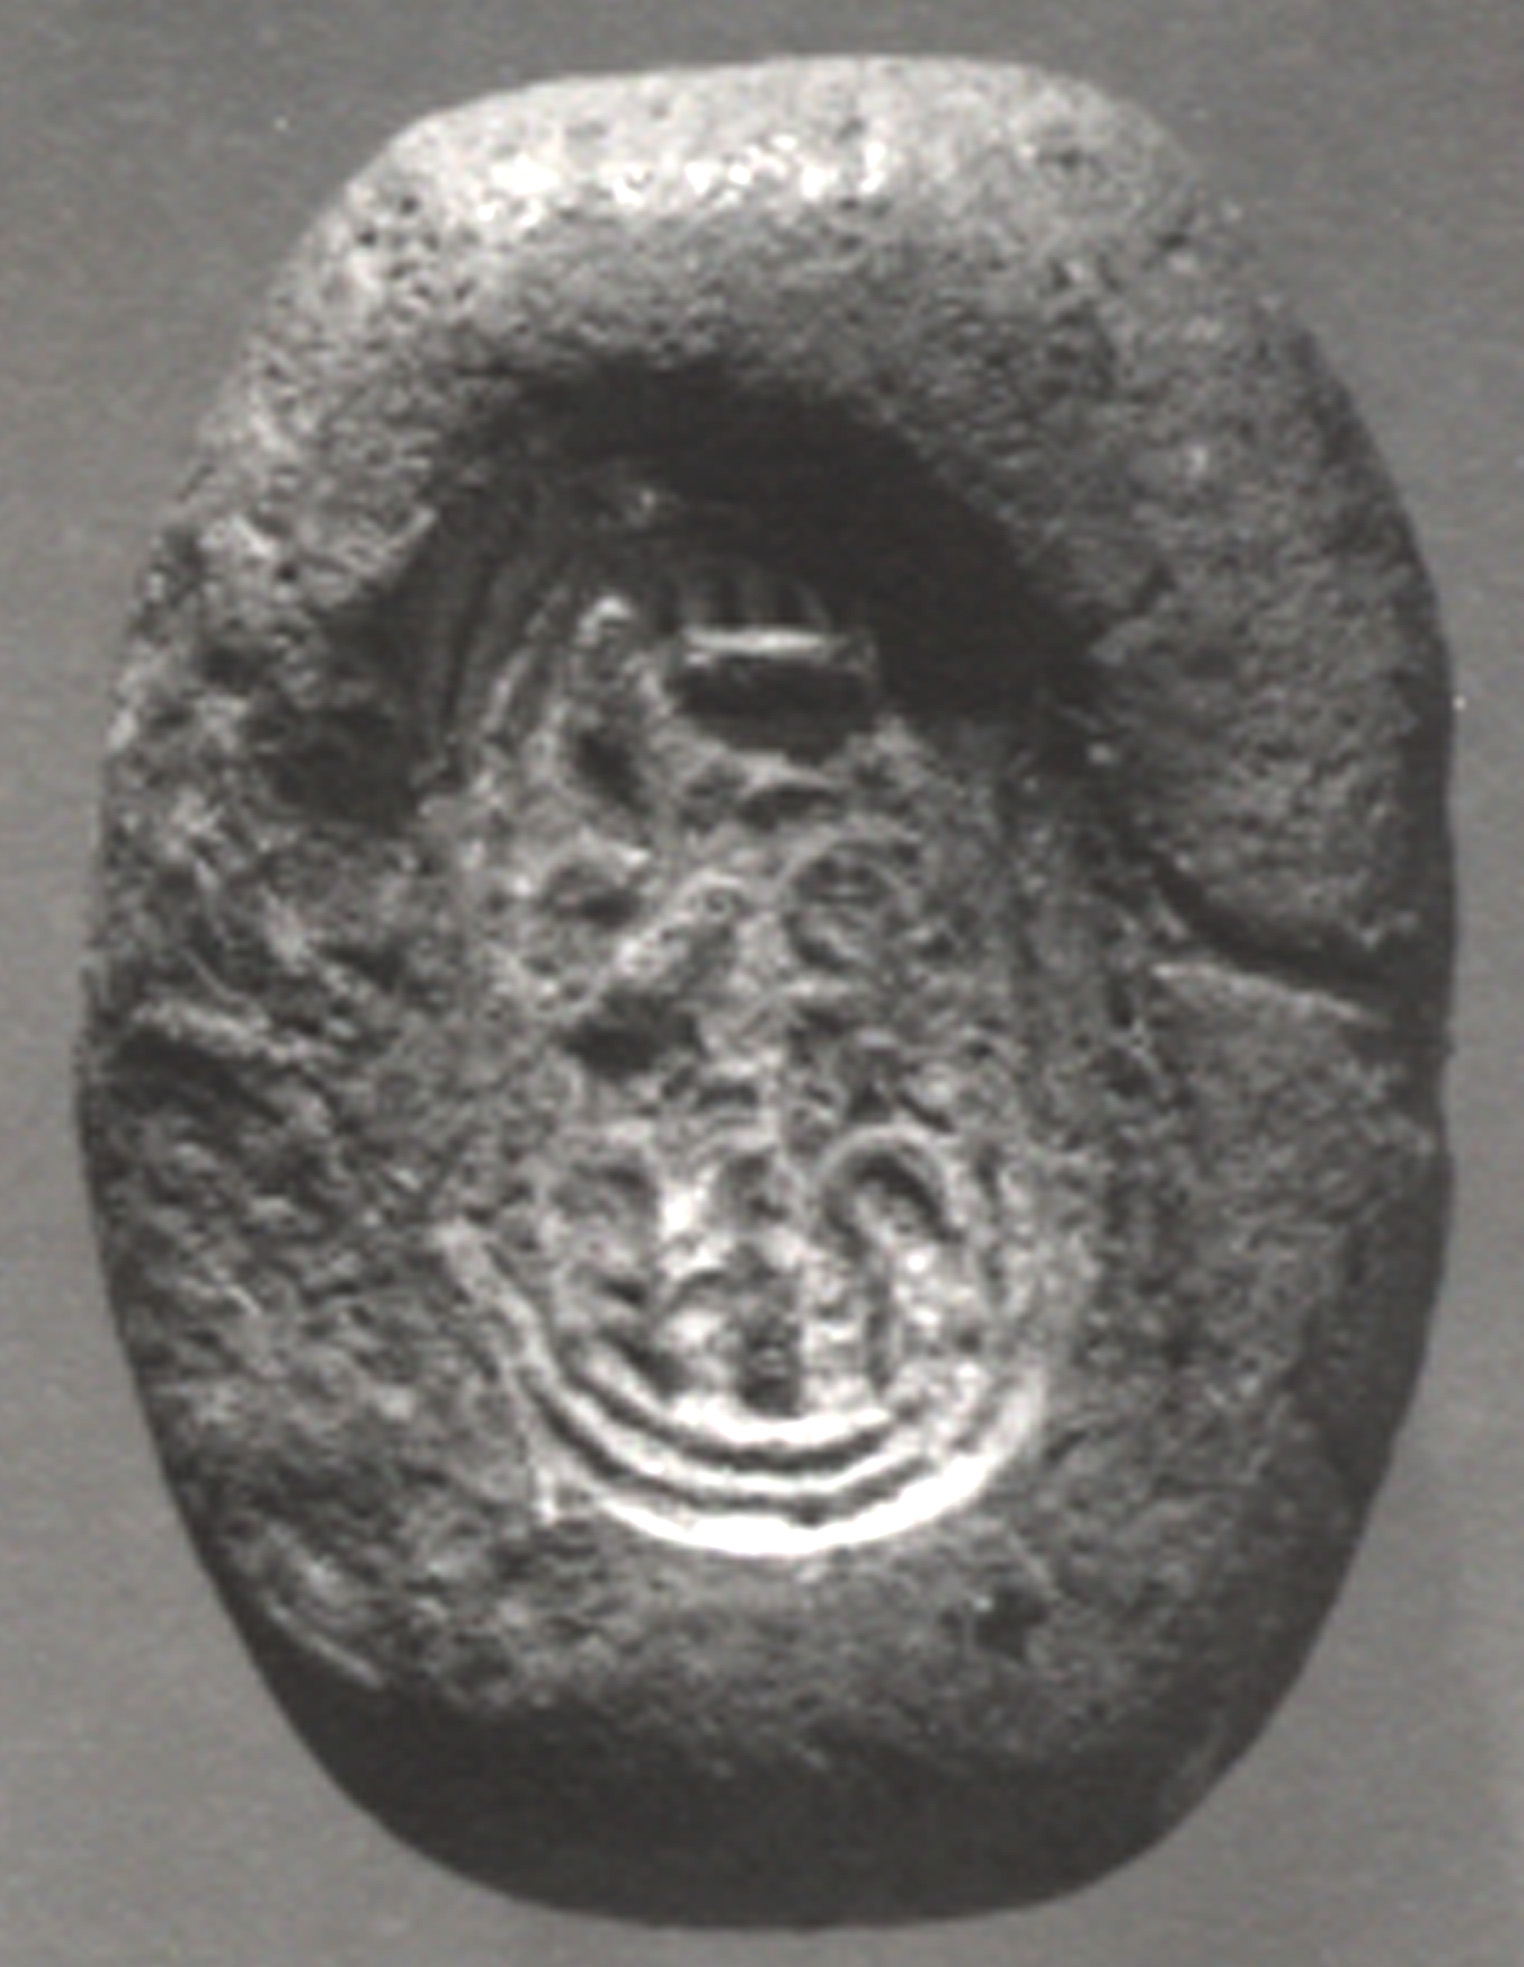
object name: mold, ring bezel, cartouche, tutankhamun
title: Ring Bezel Mold with the Cartouche of Tutankhamun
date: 1550-1295 BCE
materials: pottery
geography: egypt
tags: cartouches